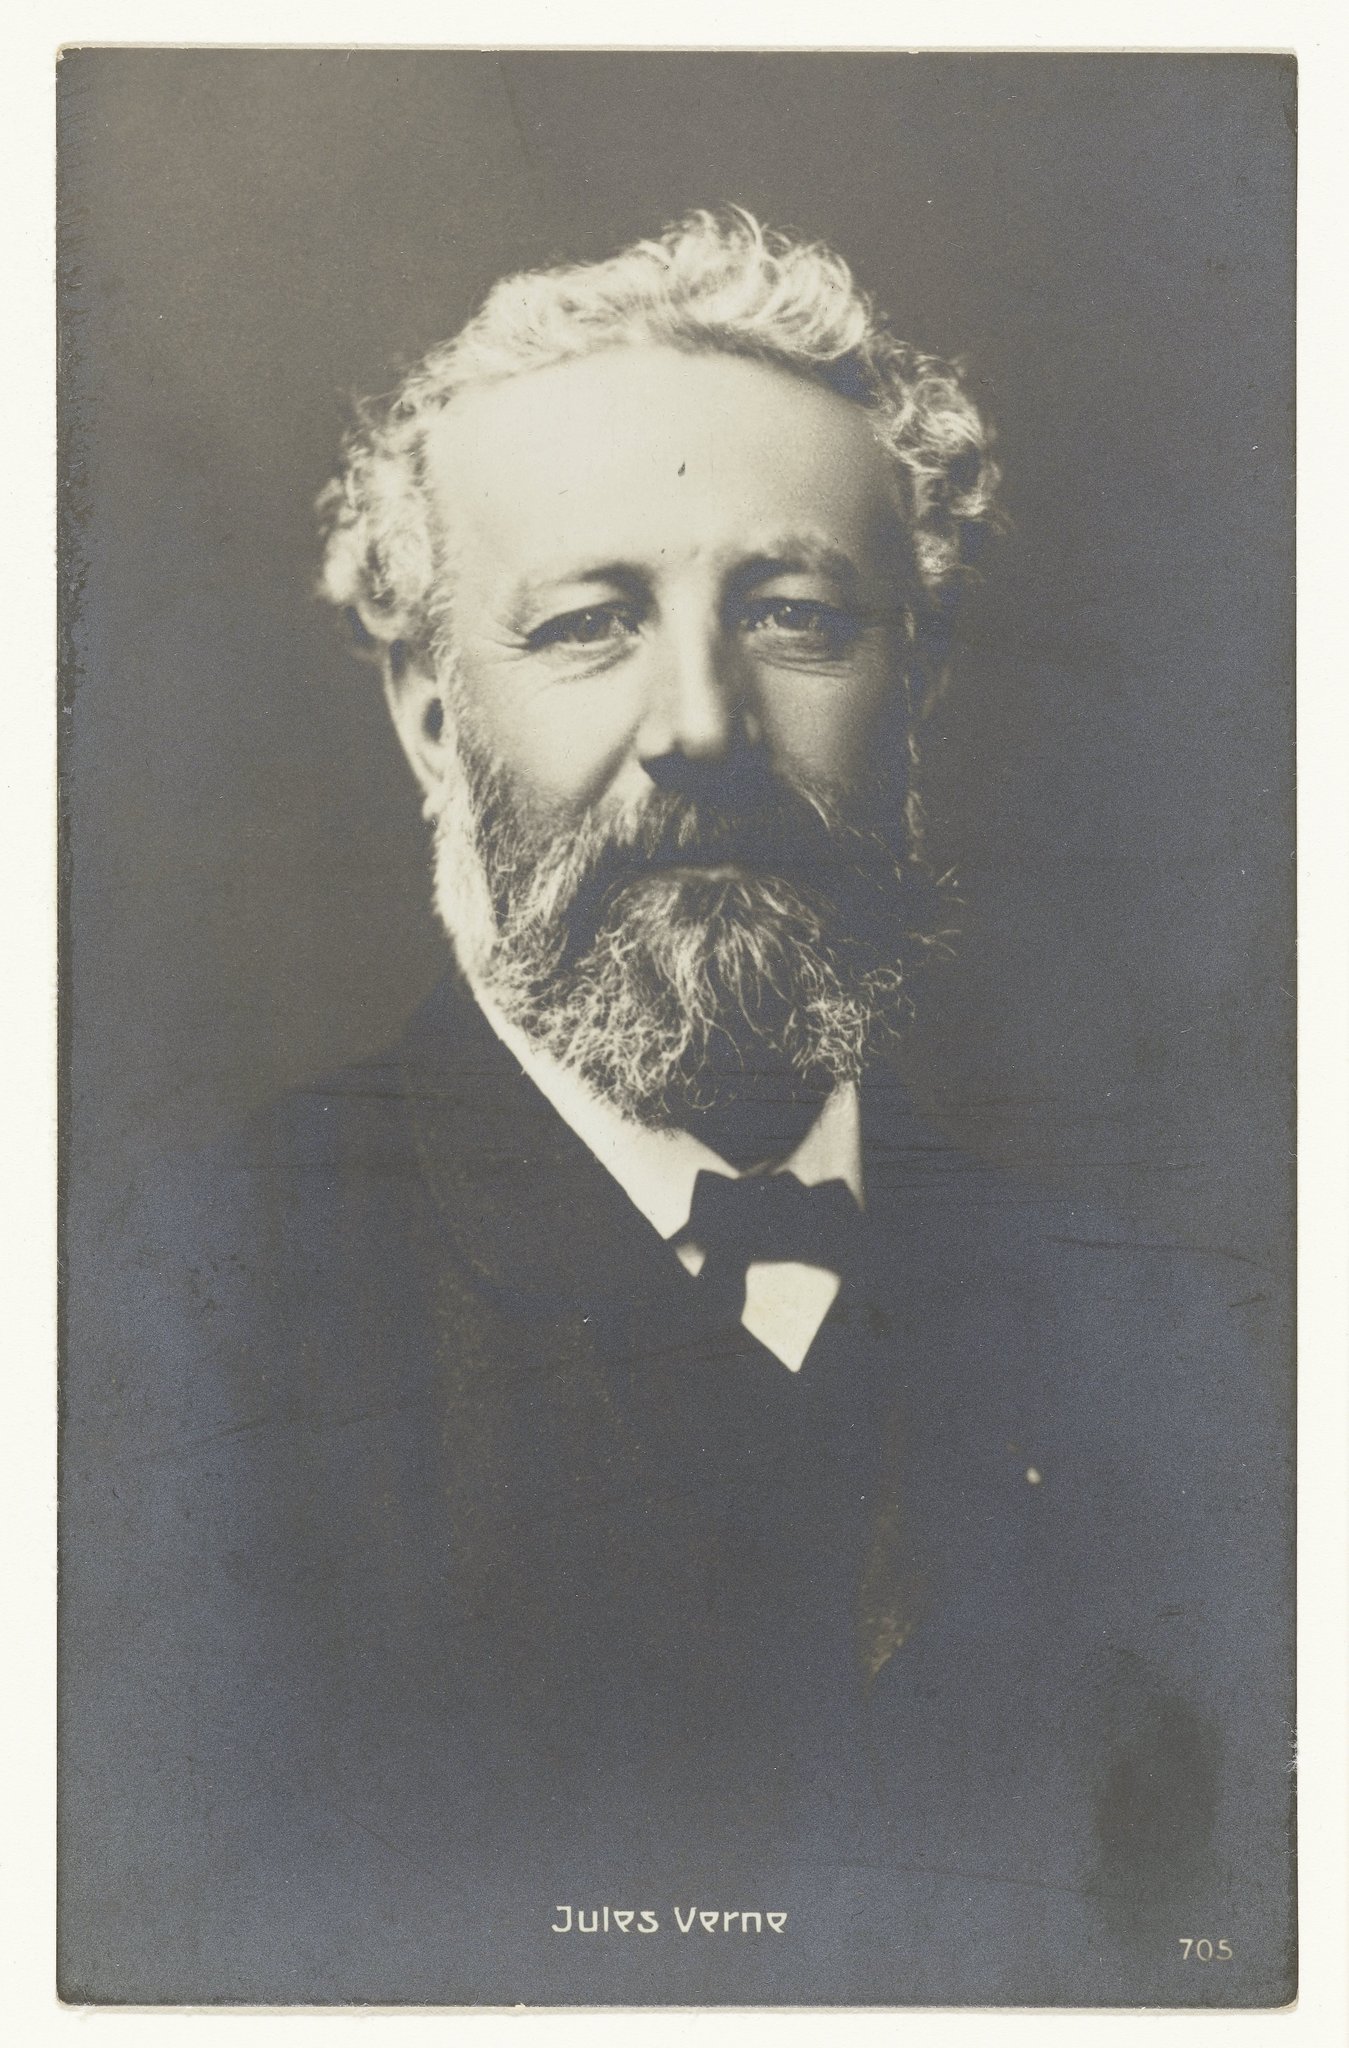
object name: ansichtkaart, prentbriefkaart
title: Jules Verne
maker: Anonymous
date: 1895-1940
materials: cardboard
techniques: gelatin silver print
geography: france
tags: adult man, historical persons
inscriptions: number: ‘705’